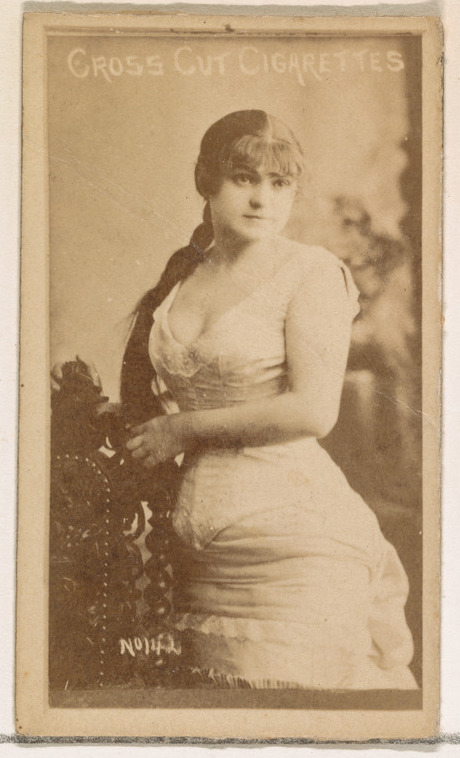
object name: print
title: Card Number 142, from the Actors and Actresses series (N145-1) issued by Duke Sons & Co. to promote Cross Cut Cigarettes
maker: w. duke, sons & co.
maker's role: publisher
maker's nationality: american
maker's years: 1870-1920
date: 1880-1889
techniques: albumen silver print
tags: portraits,women,actresses